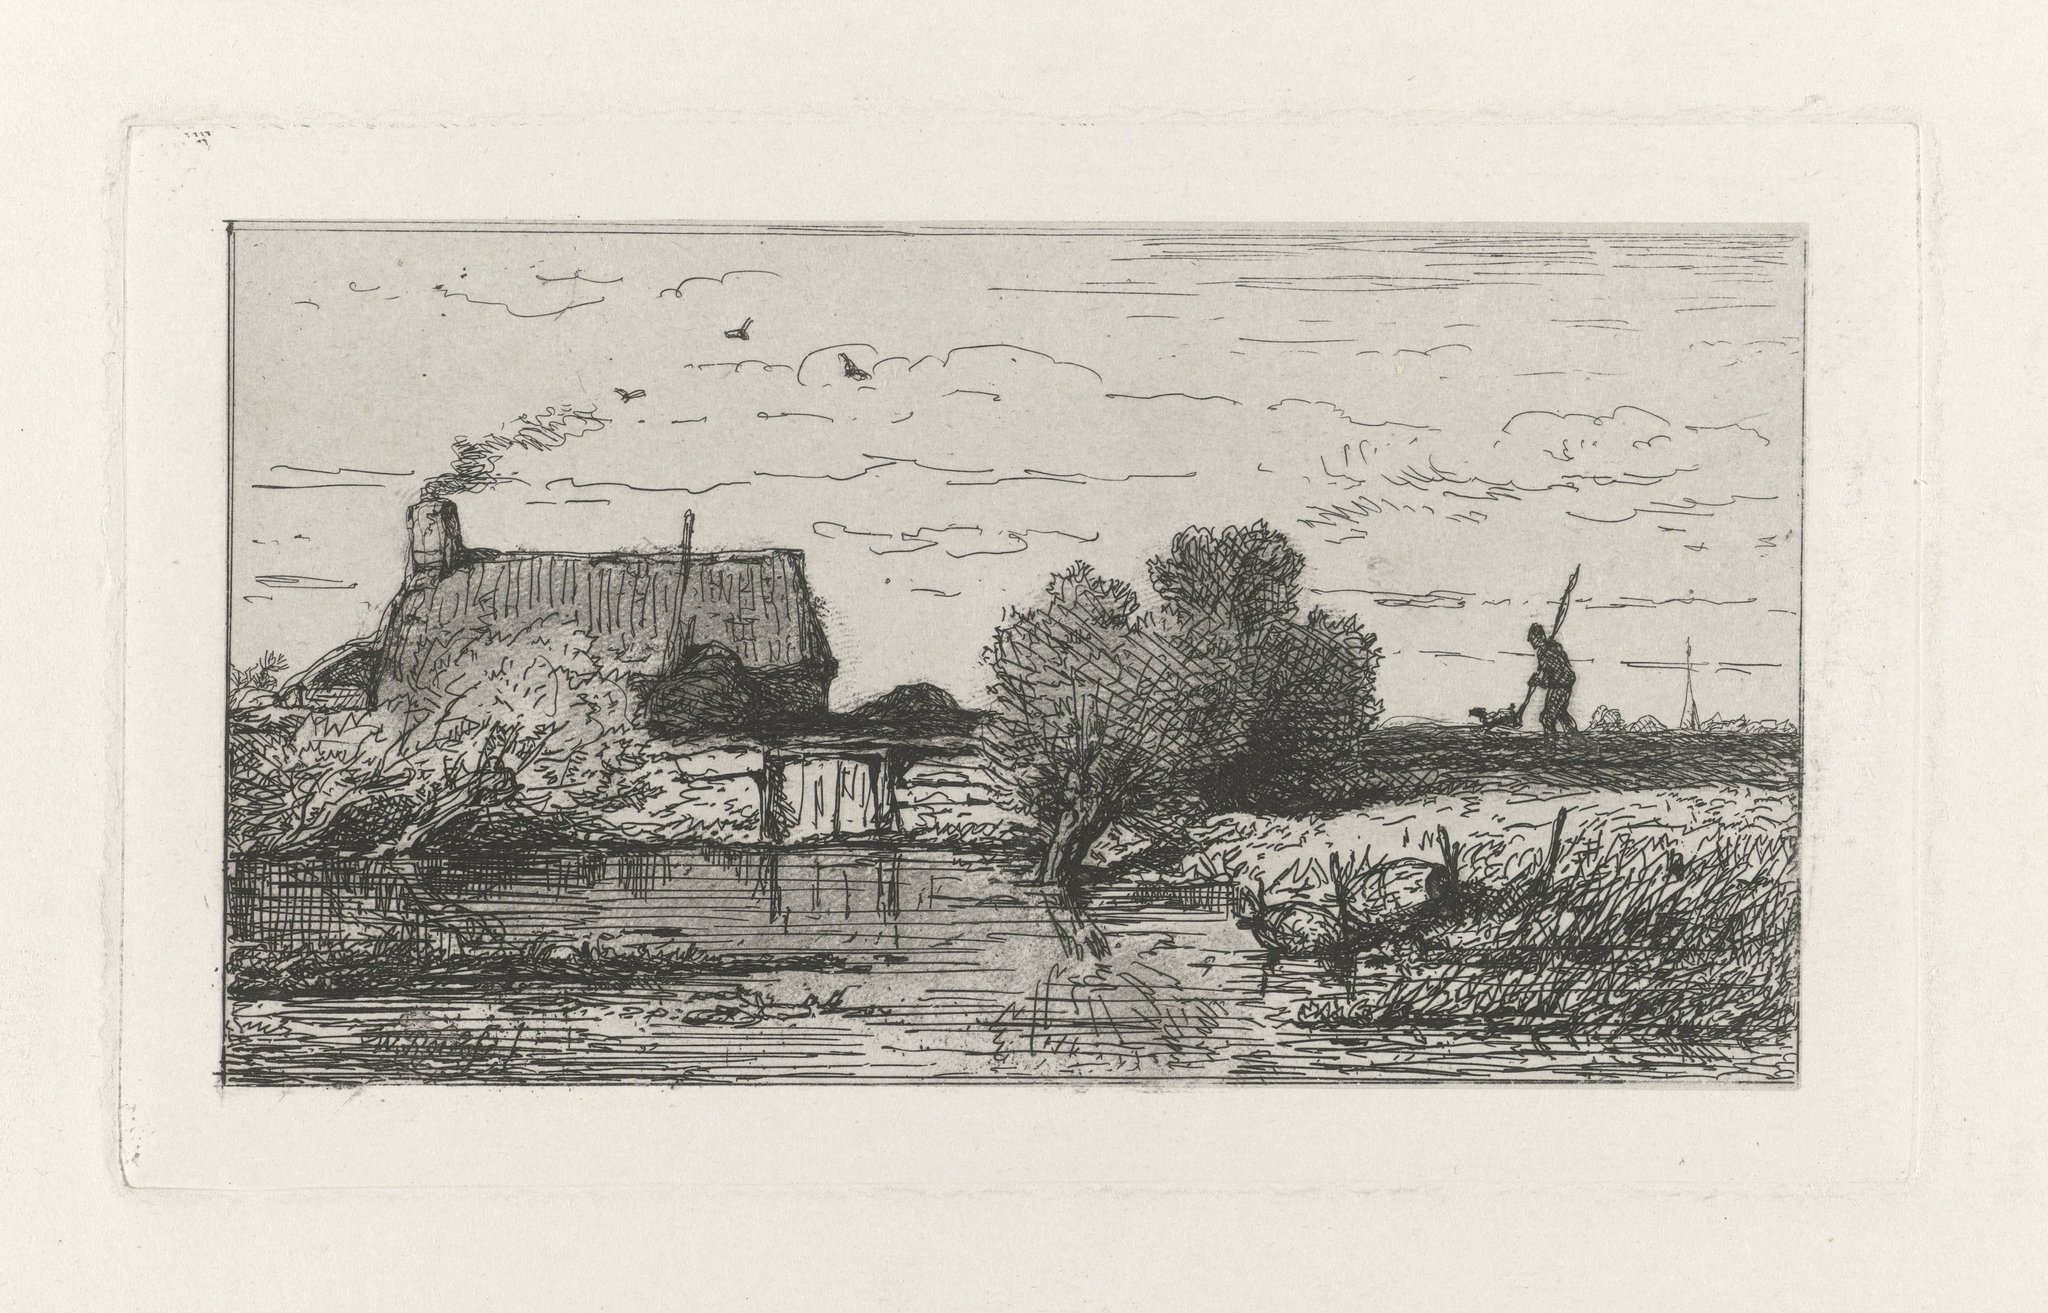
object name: print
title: Gezicht op een boerderij aan het water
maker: willem roelofs (i)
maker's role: draughtsman, painter, print maker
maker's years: 1822-1897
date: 1832-1897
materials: paper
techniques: drypoint, etching, intaglio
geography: netherlands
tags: prospect of village, silhouette of village, pond, farm or solitary house in landscape, dog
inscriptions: collector's mark: Lugt 2228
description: Landschap met een boerenhoeve aan een waterpoel. Rechts een wandelaar met hond. Op de achtergrond de contouren van een dorp.